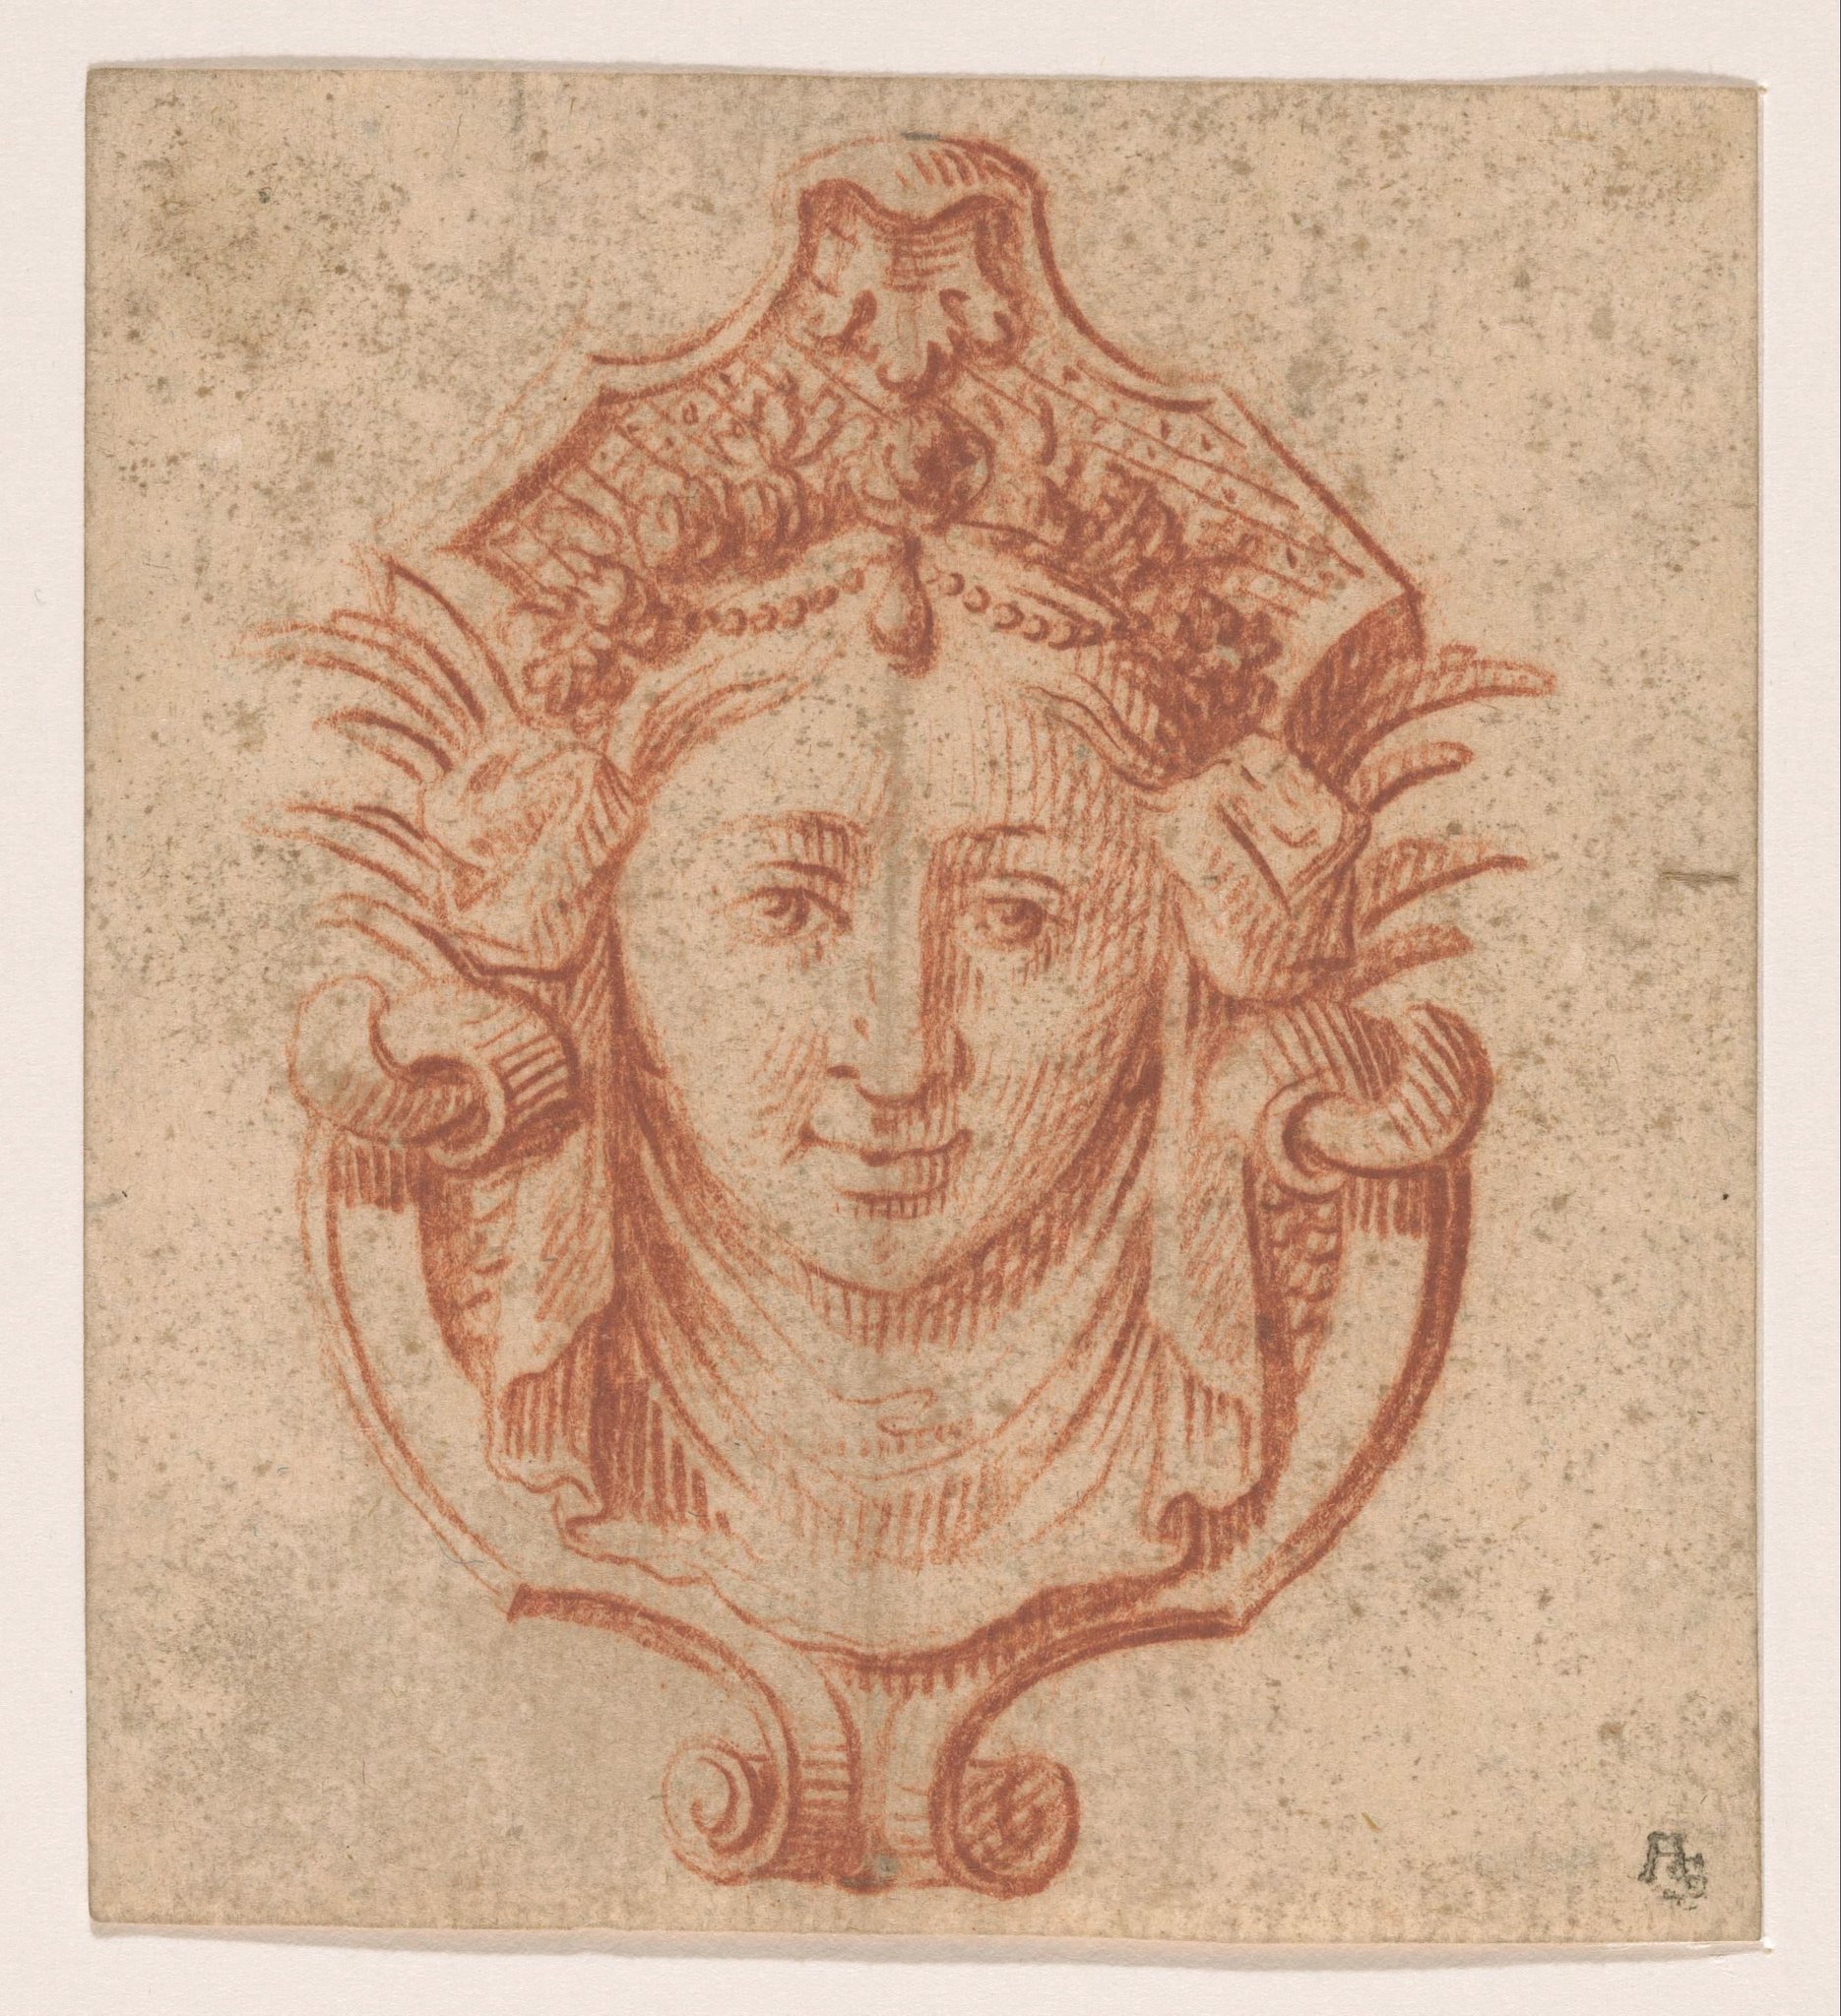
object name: design drawing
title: Schild van rolwerk met een vrouwenhoofd boven een draperie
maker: Anonymous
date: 1700-1725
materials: chalk, paper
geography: paris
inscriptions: collector's mark: Lugt 175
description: Schild van rolwerk met een vrouwenhoofd boven een draperie, getooid met een parelsnoer en een kroon in de vorm van de boeg van een schip, bezet met een bloemslinger, het hoofd geflankeerd door palmtakken, waarschijnlijk ontwerp voor een beslagstuk.